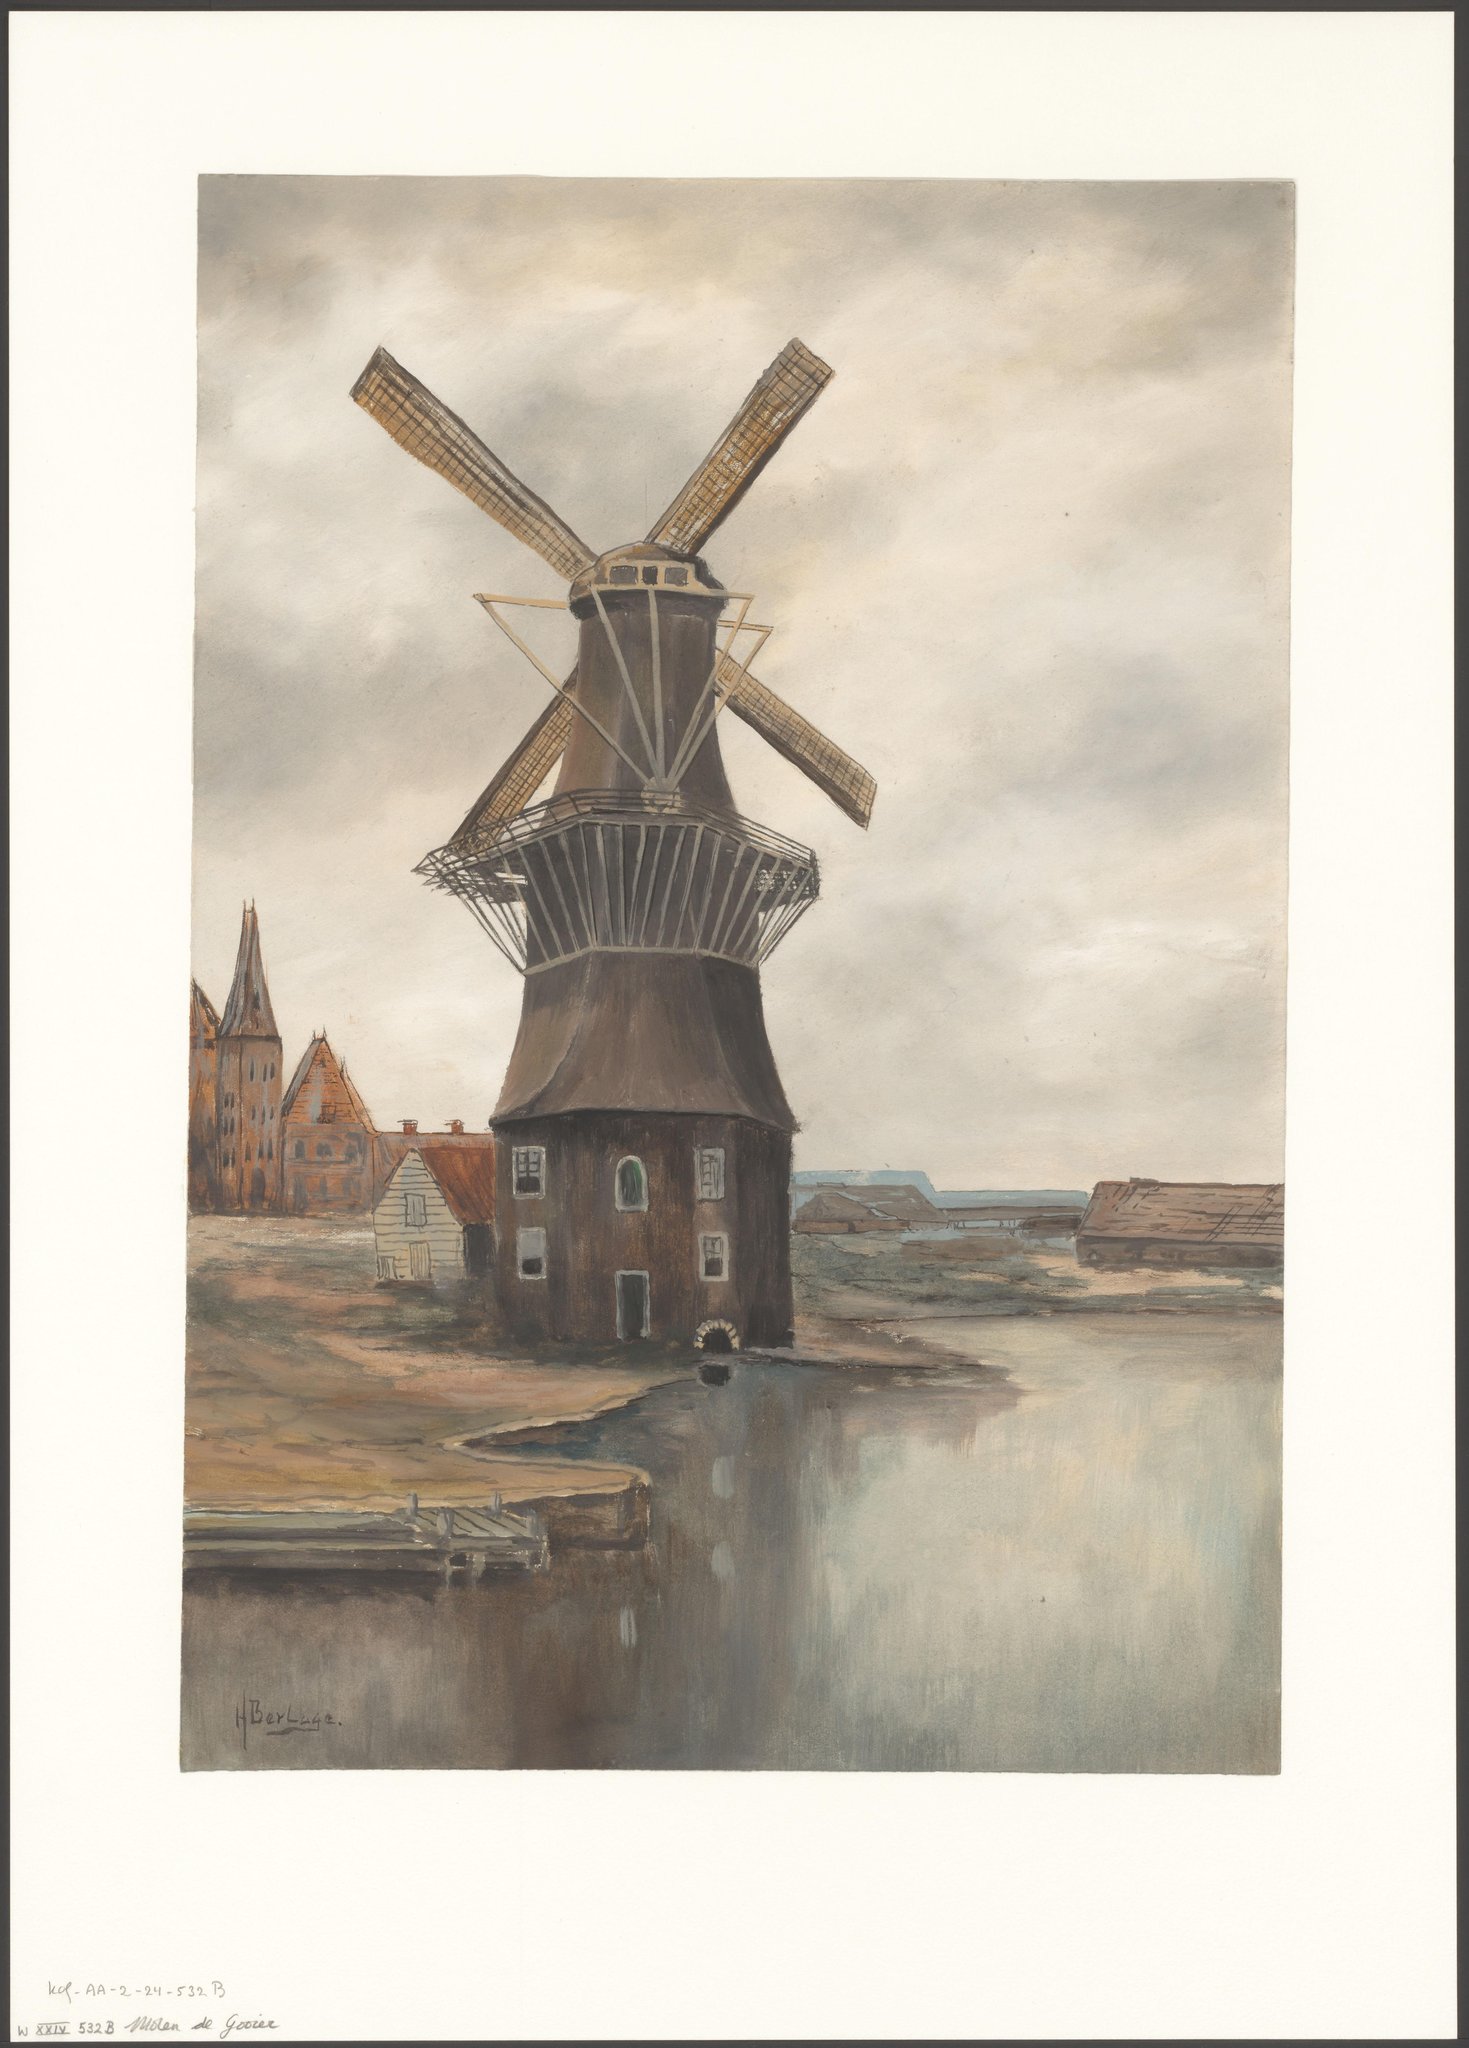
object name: drawing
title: Gezicht op molen De Gooyer aan de Funenkade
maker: herman josef marie berlage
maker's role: draughtsman, painter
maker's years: 1875-1943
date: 1895-1943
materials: paint, paper, pencil, watercolor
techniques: brush, pen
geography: amsterdam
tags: city-view in general; 'veduta', windmill in landscape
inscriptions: signature: ‘HBerlage.’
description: Tekening binnen de Atlas Van Eck ingedeeld op wijknummer 24.